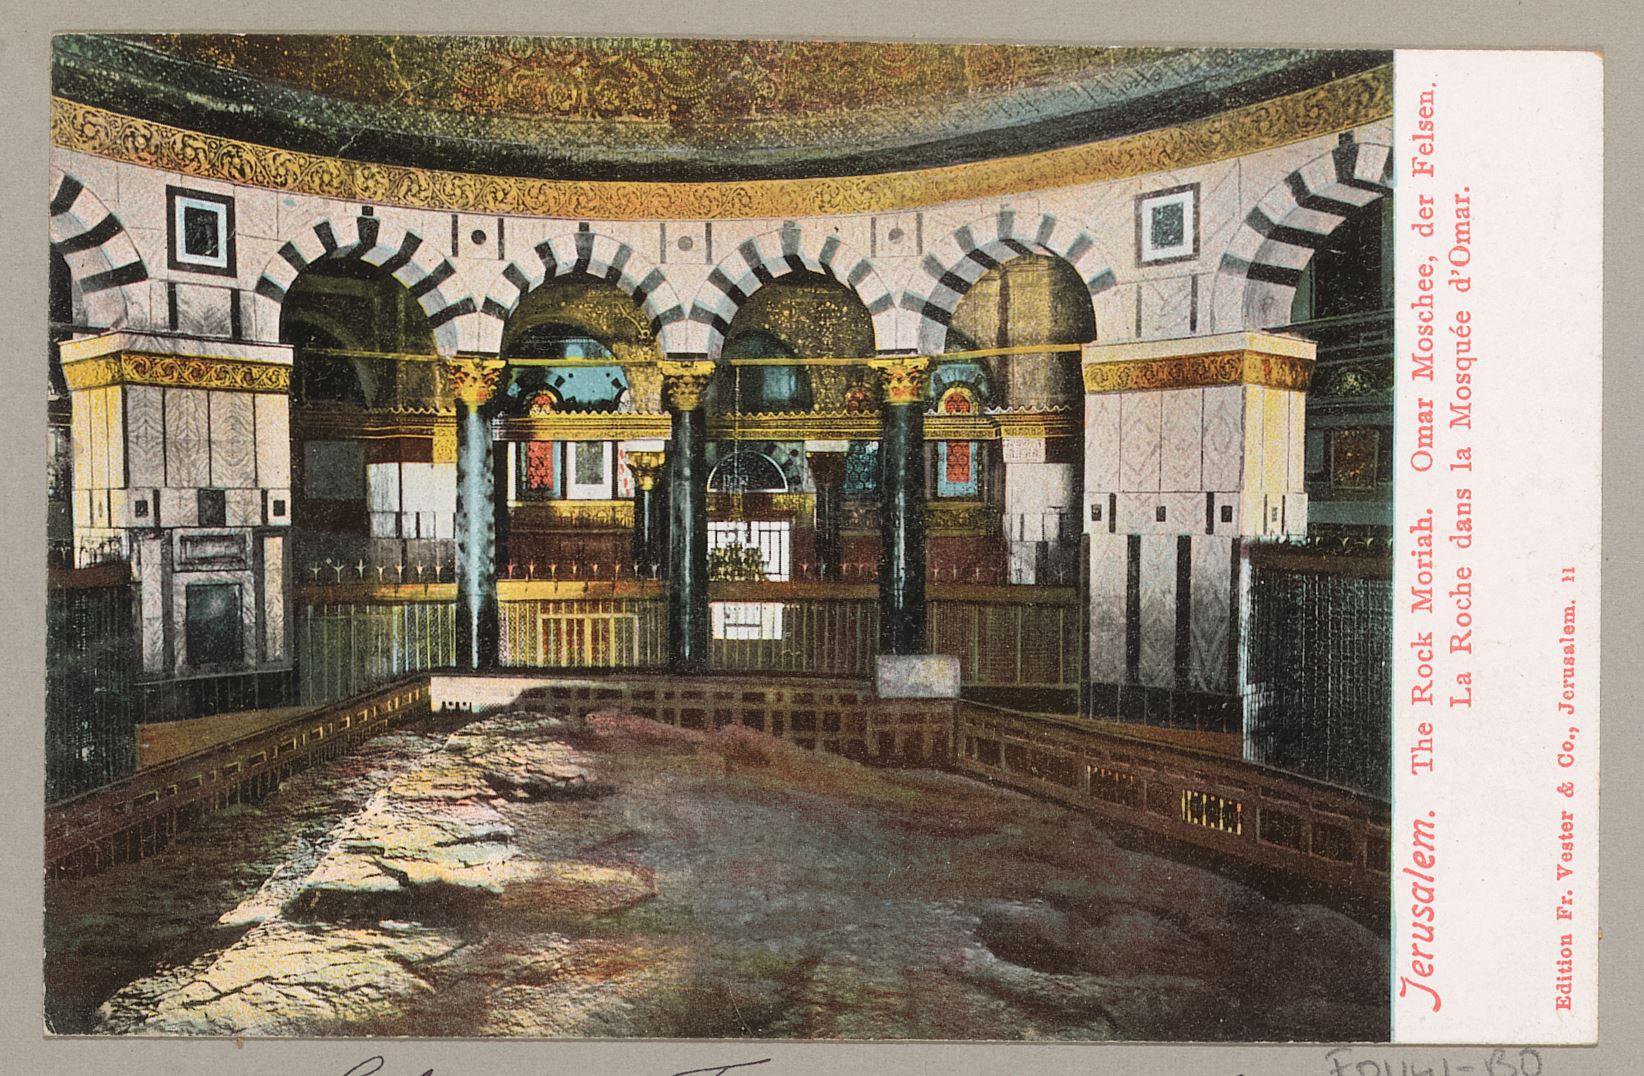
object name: ansichtkaart, prentbriefkaart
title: Interieur van de Rotskoepel in Jeruzalem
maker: Anonymous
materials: paper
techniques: chromolithography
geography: jerusalem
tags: temple, shrine ~ islam, mohammedanism, rock-formations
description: Onderdeel van Fotoalbum van een reis door Zuid-Europa en het Midden-Oosten.